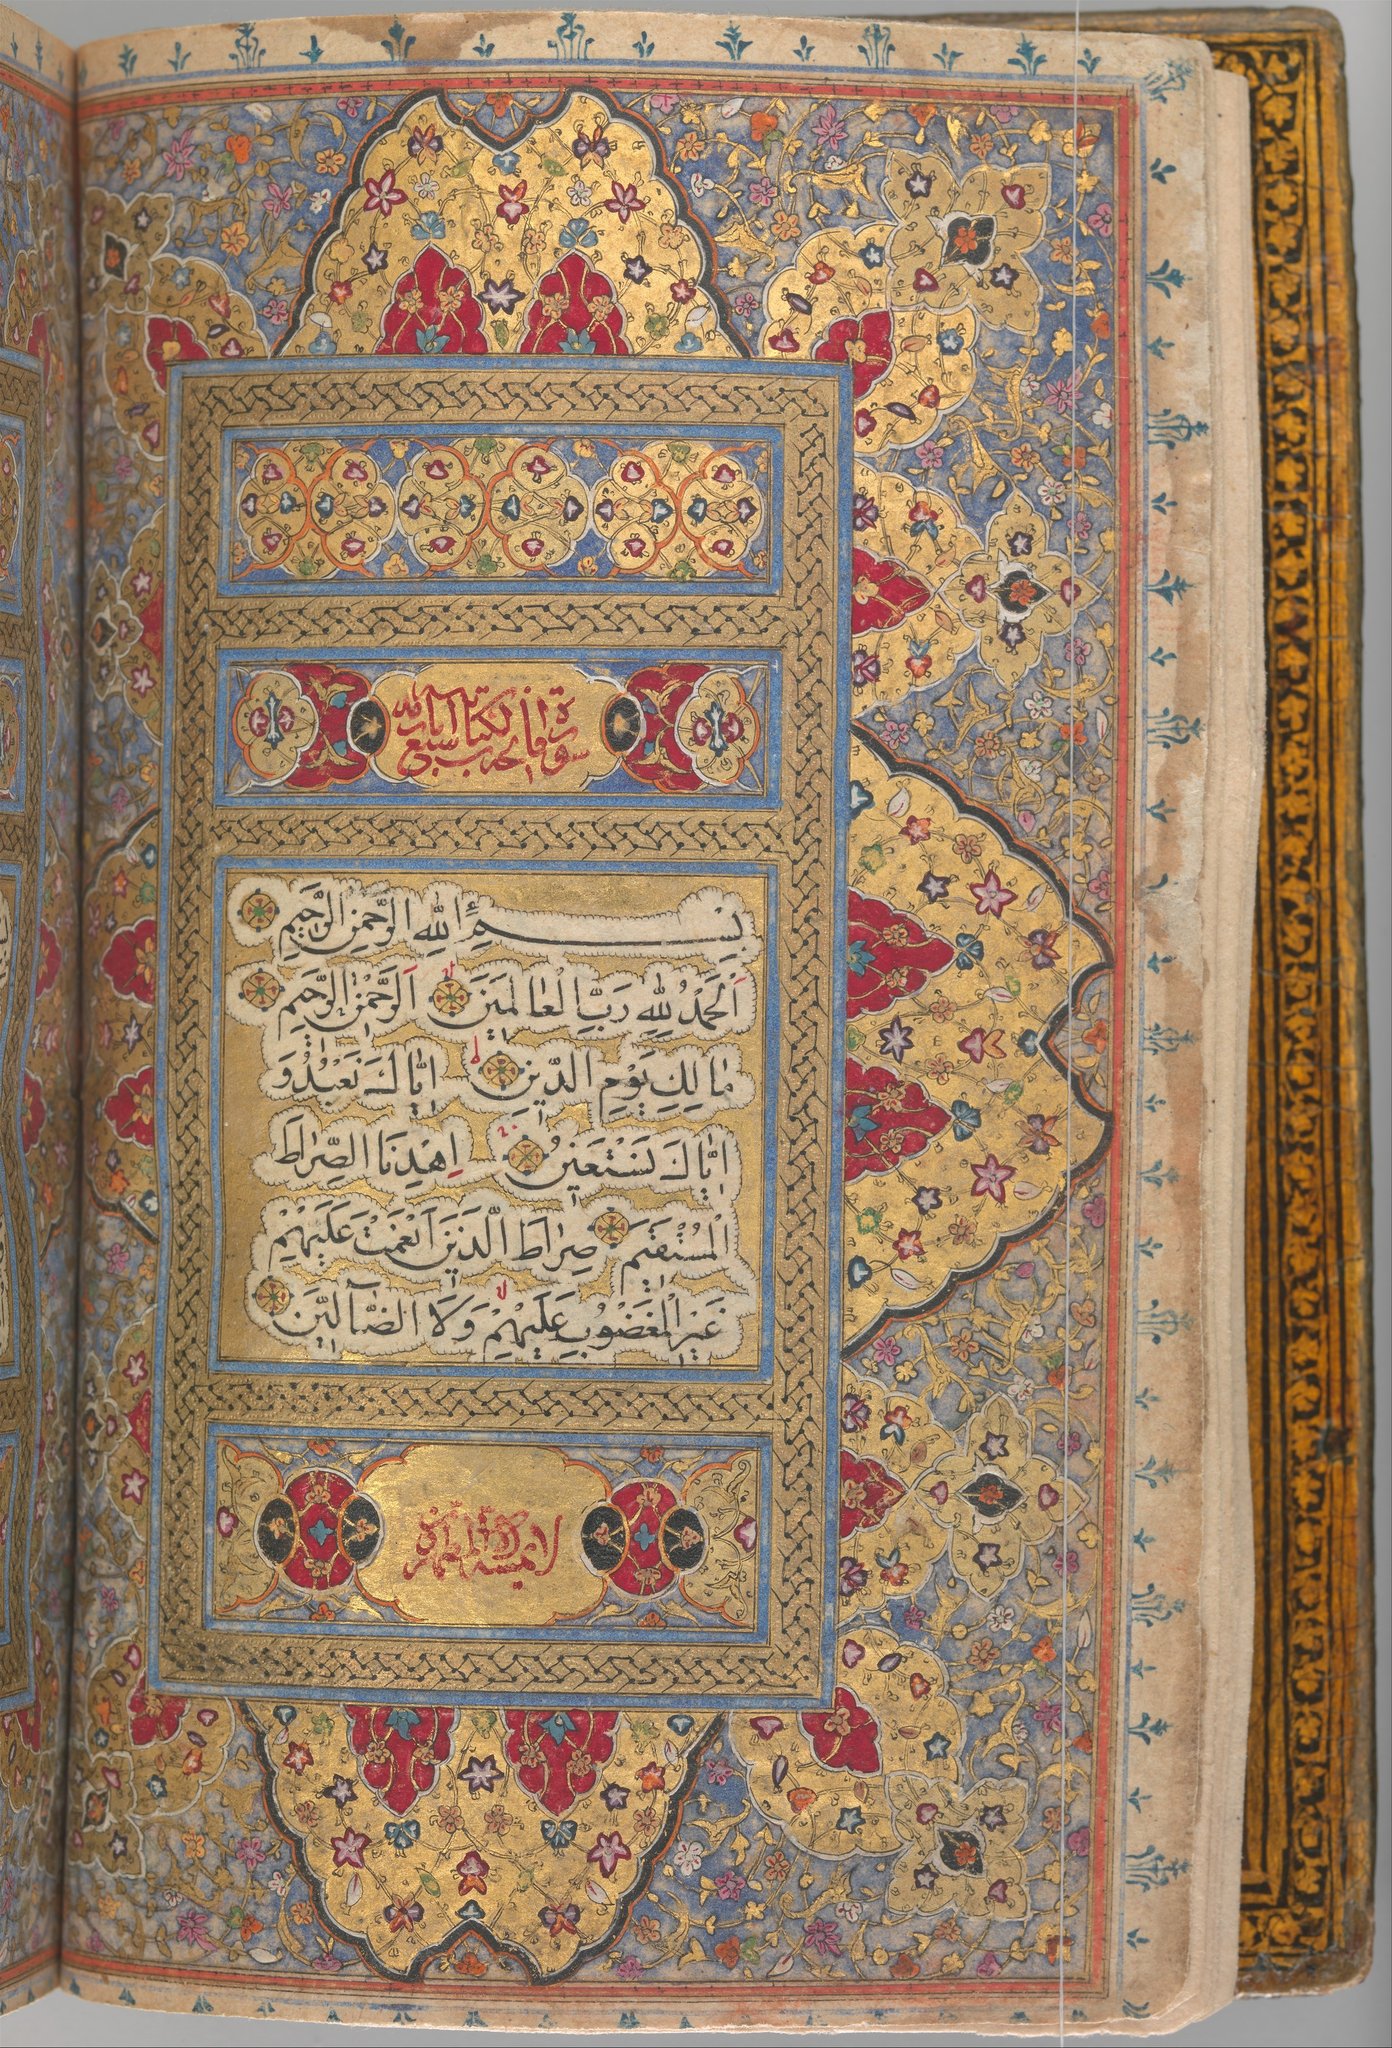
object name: non illustrated manuscript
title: Qur'an Manuscript with Lacquer Binding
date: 1801-1833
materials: gold, ink, paper, board, watercolor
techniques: bookbinding, lacquer, painting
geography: iran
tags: qur'an